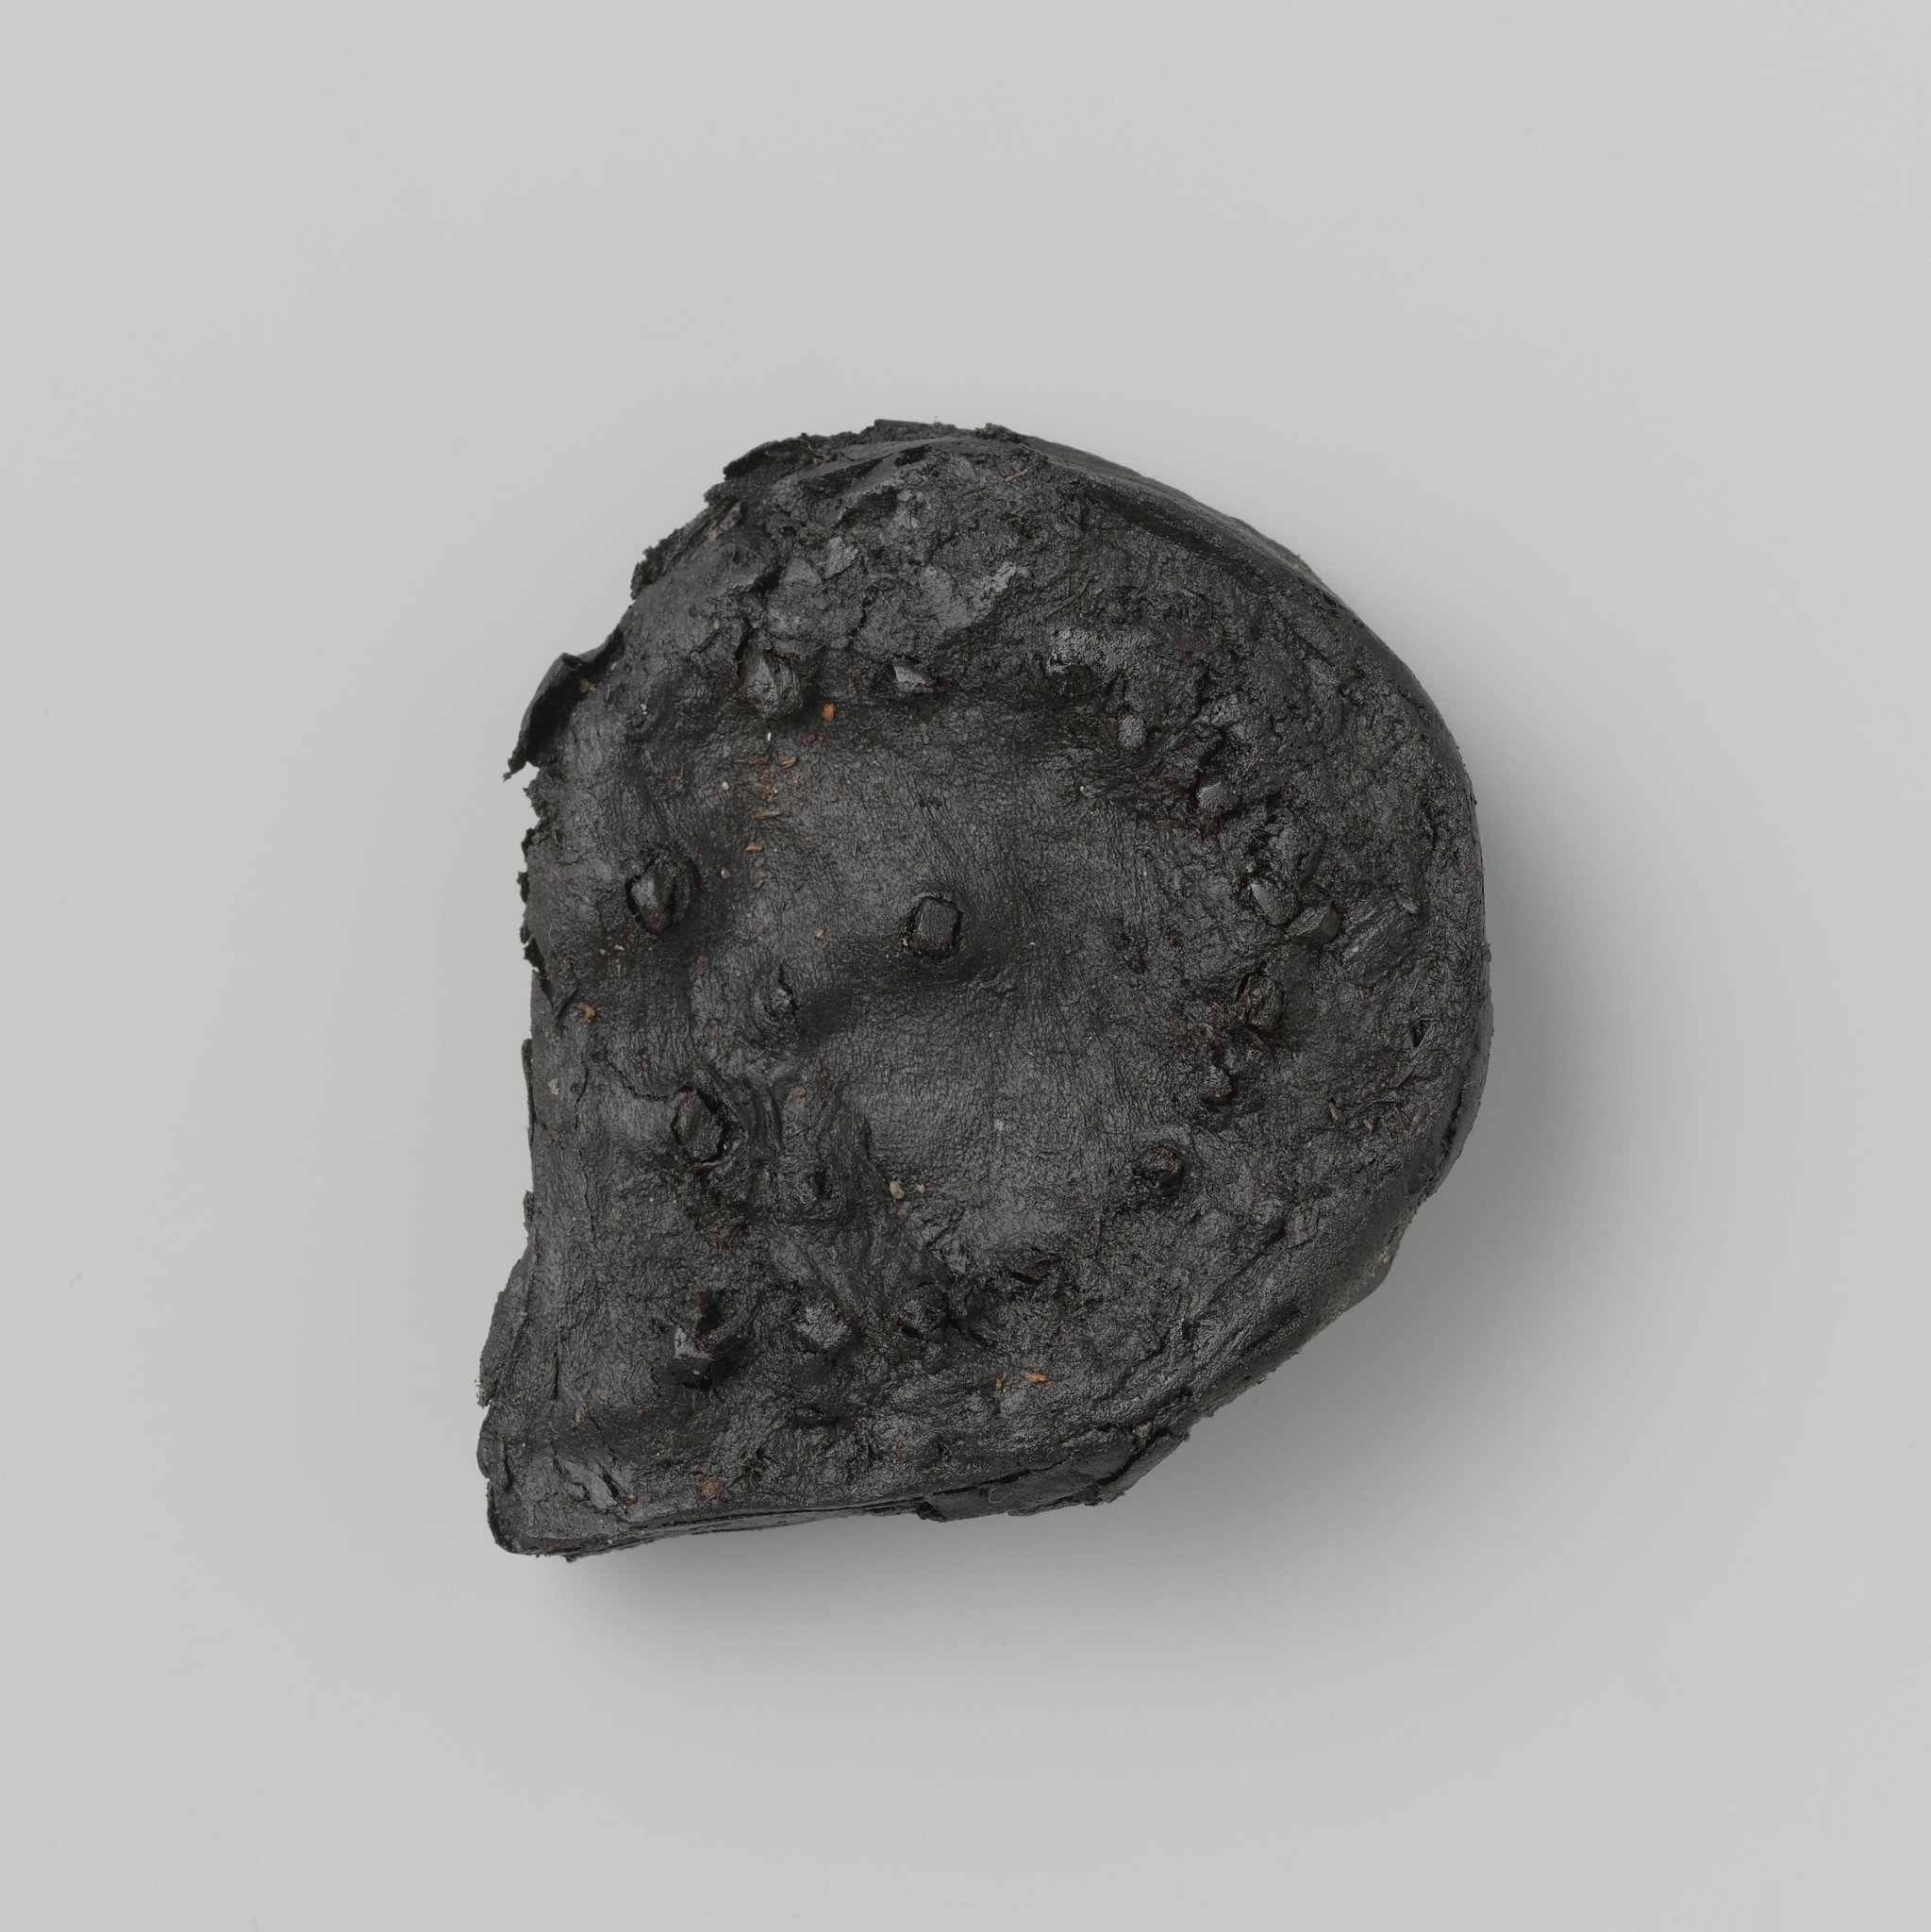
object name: shoe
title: Hak van een schoenzool uit het wrak van de Oost-Indiëvaarder Hollandia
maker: Anonymous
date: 1700-1743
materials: leather, wood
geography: netherlands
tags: verenigde oostindische compagnie, hollandia (schip), annet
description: Shoe; fragm, heel with pins, sim. NG 1980-27H2232.